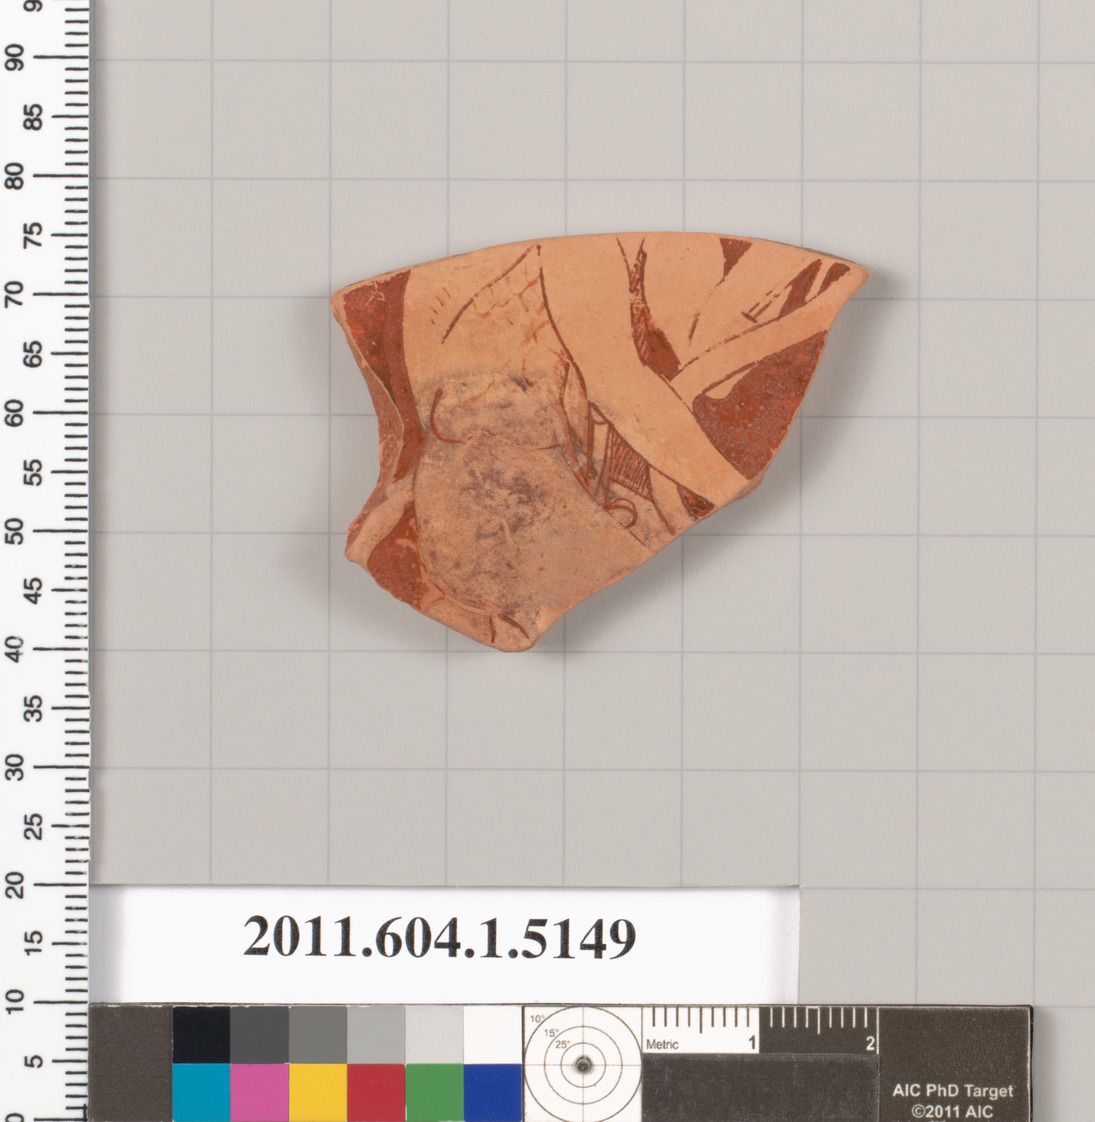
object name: kylix fragment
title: Terracotta fragment of a kylix (drinking cup)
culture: greek, attic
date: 520-500 BCE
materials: terracotta